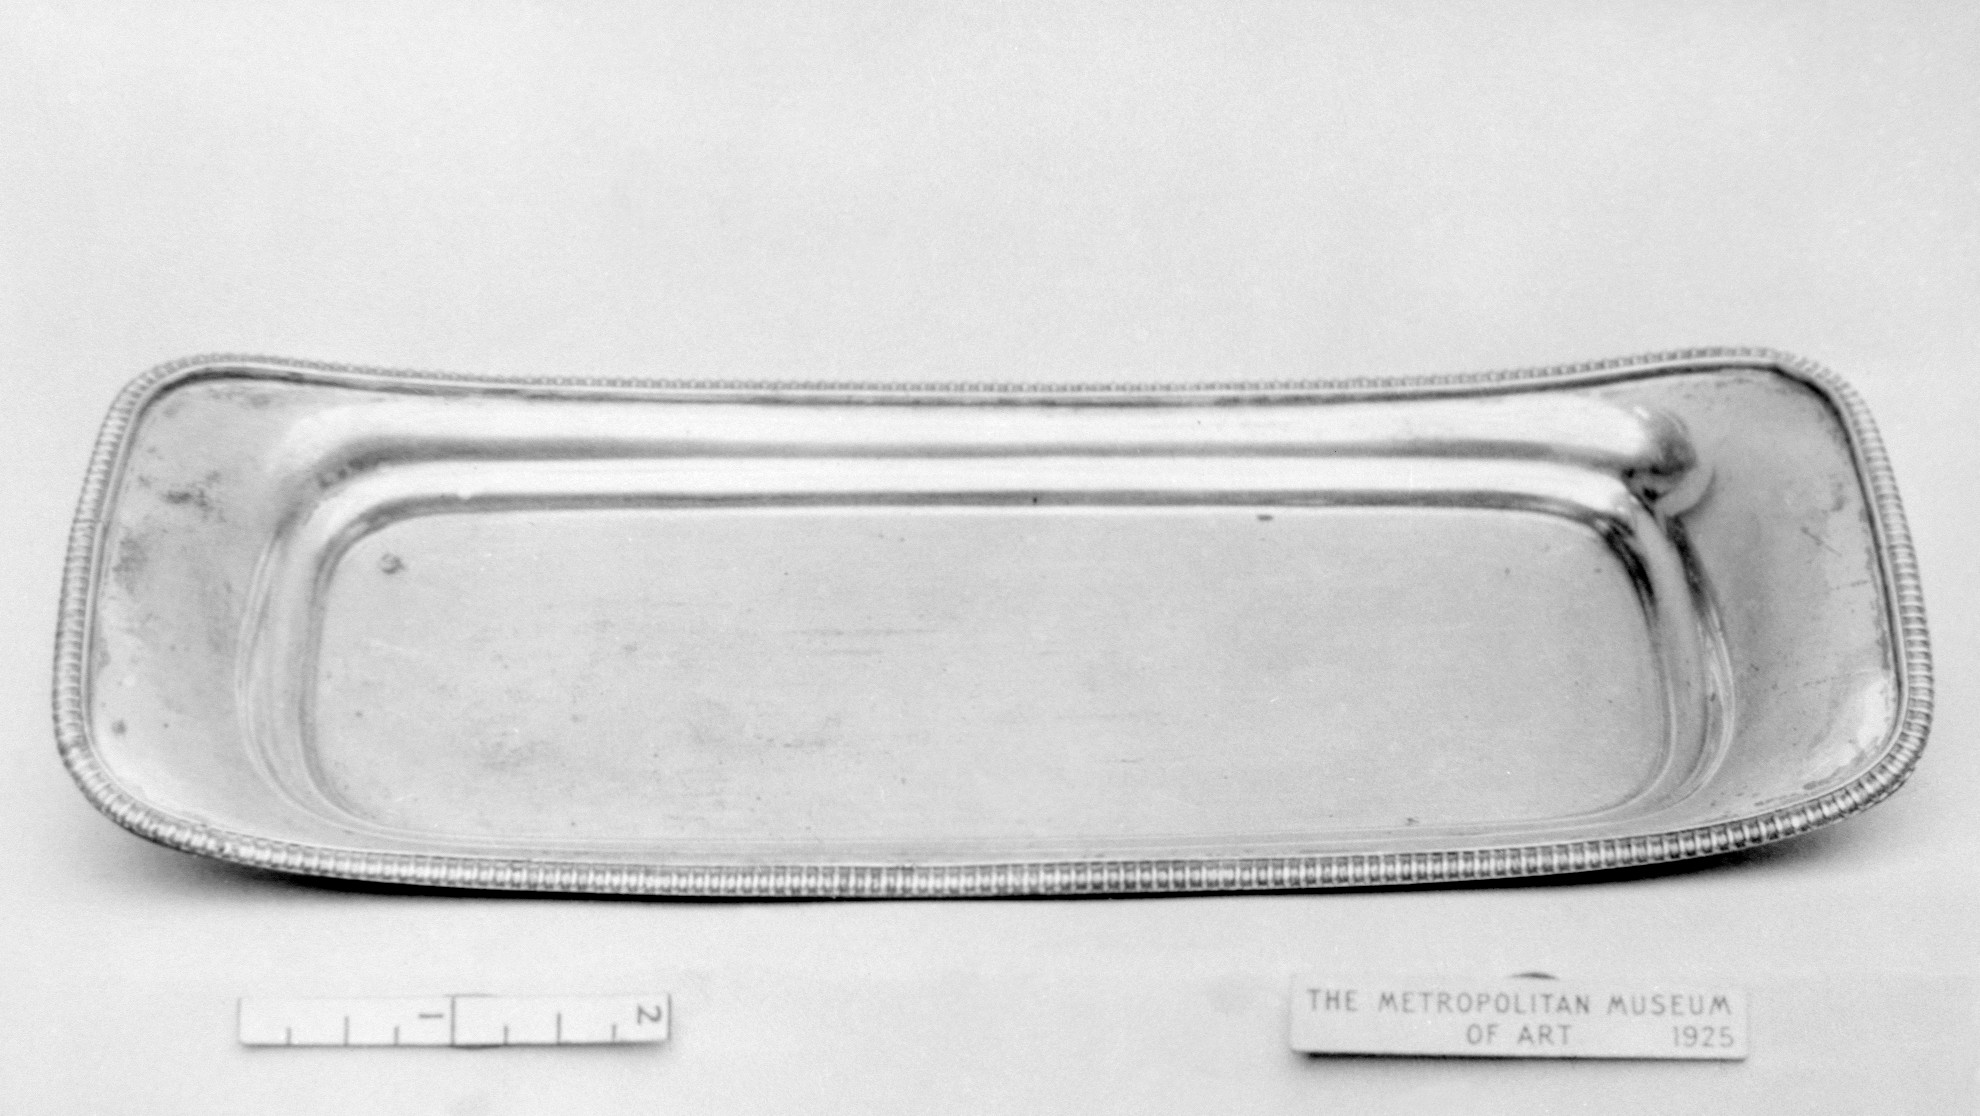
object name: snuffer tray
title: Snuffers tray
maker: d. & g. holy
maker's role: maker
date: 1820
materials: metal